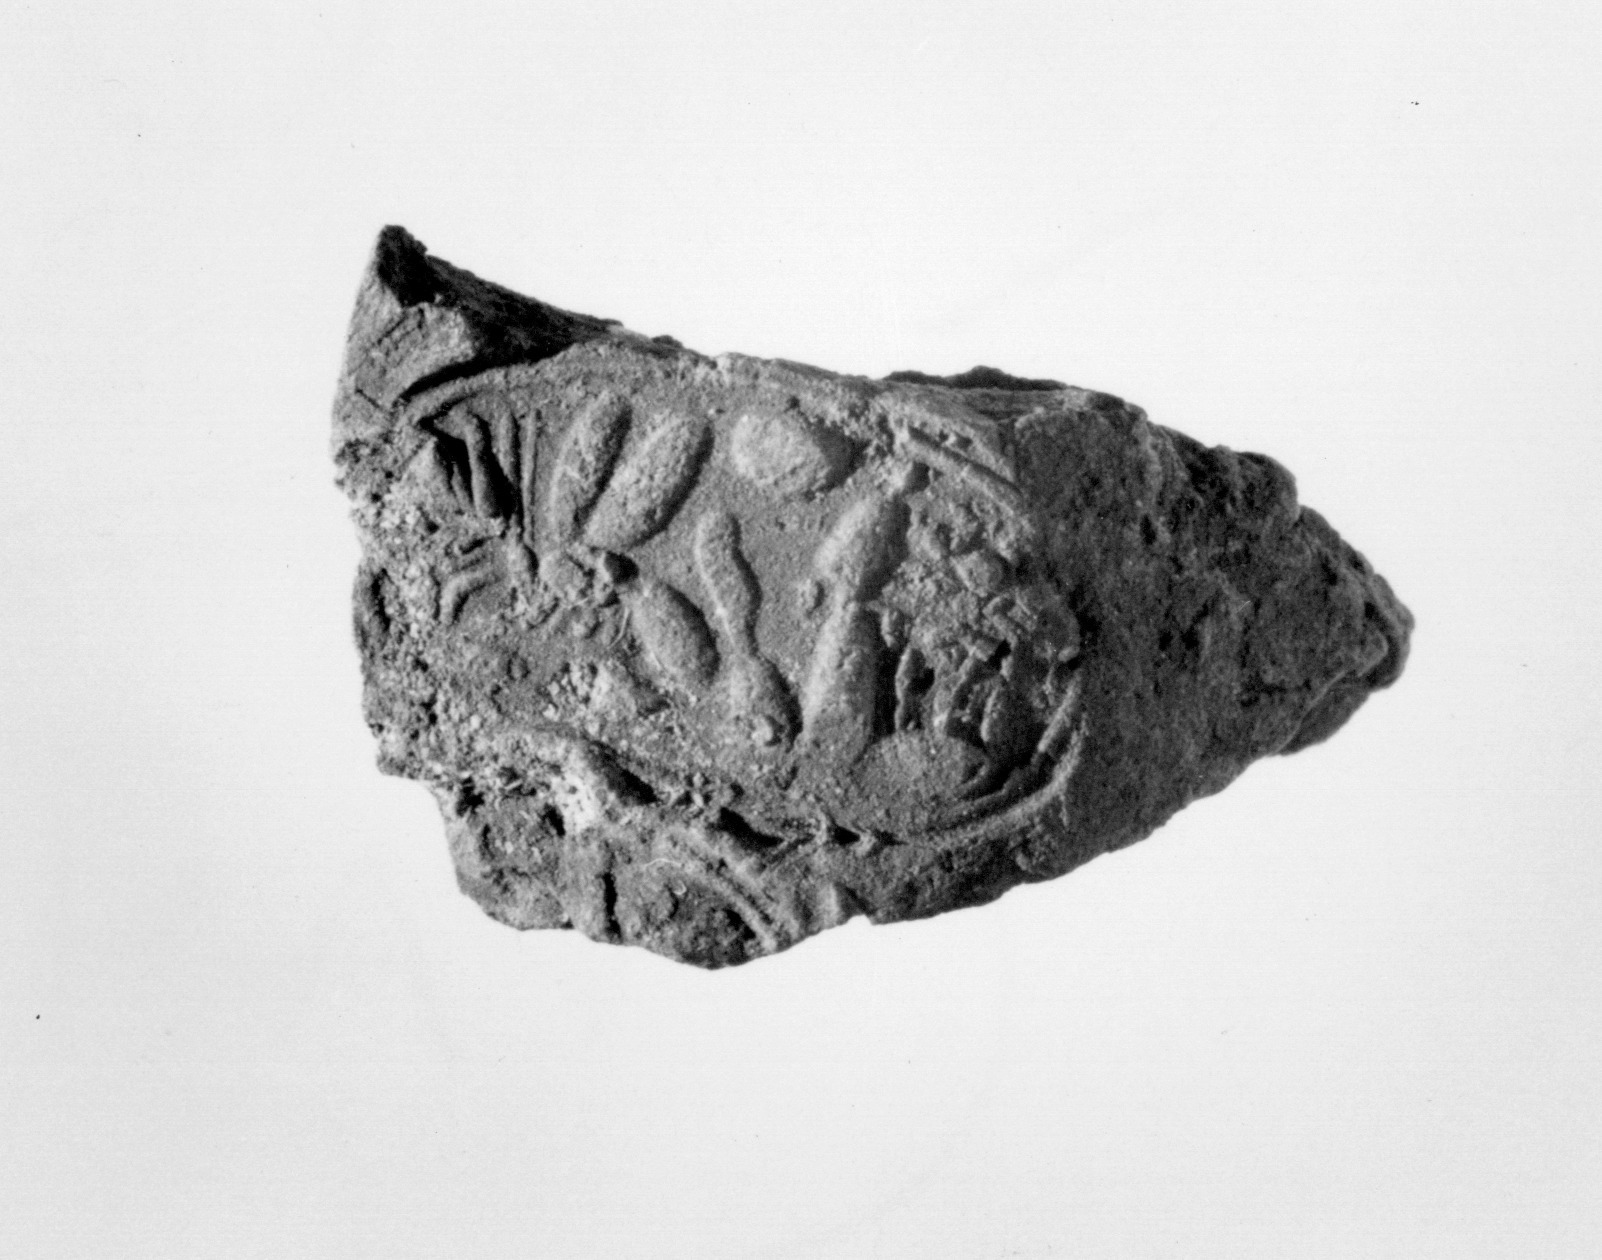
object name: sealing, nebmaatre, amenhotep iii, nesut, bity, bee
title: Document Sealing With the Throne Name of Amenhotep III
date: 1390-1352 BCE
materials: mud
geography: egypt